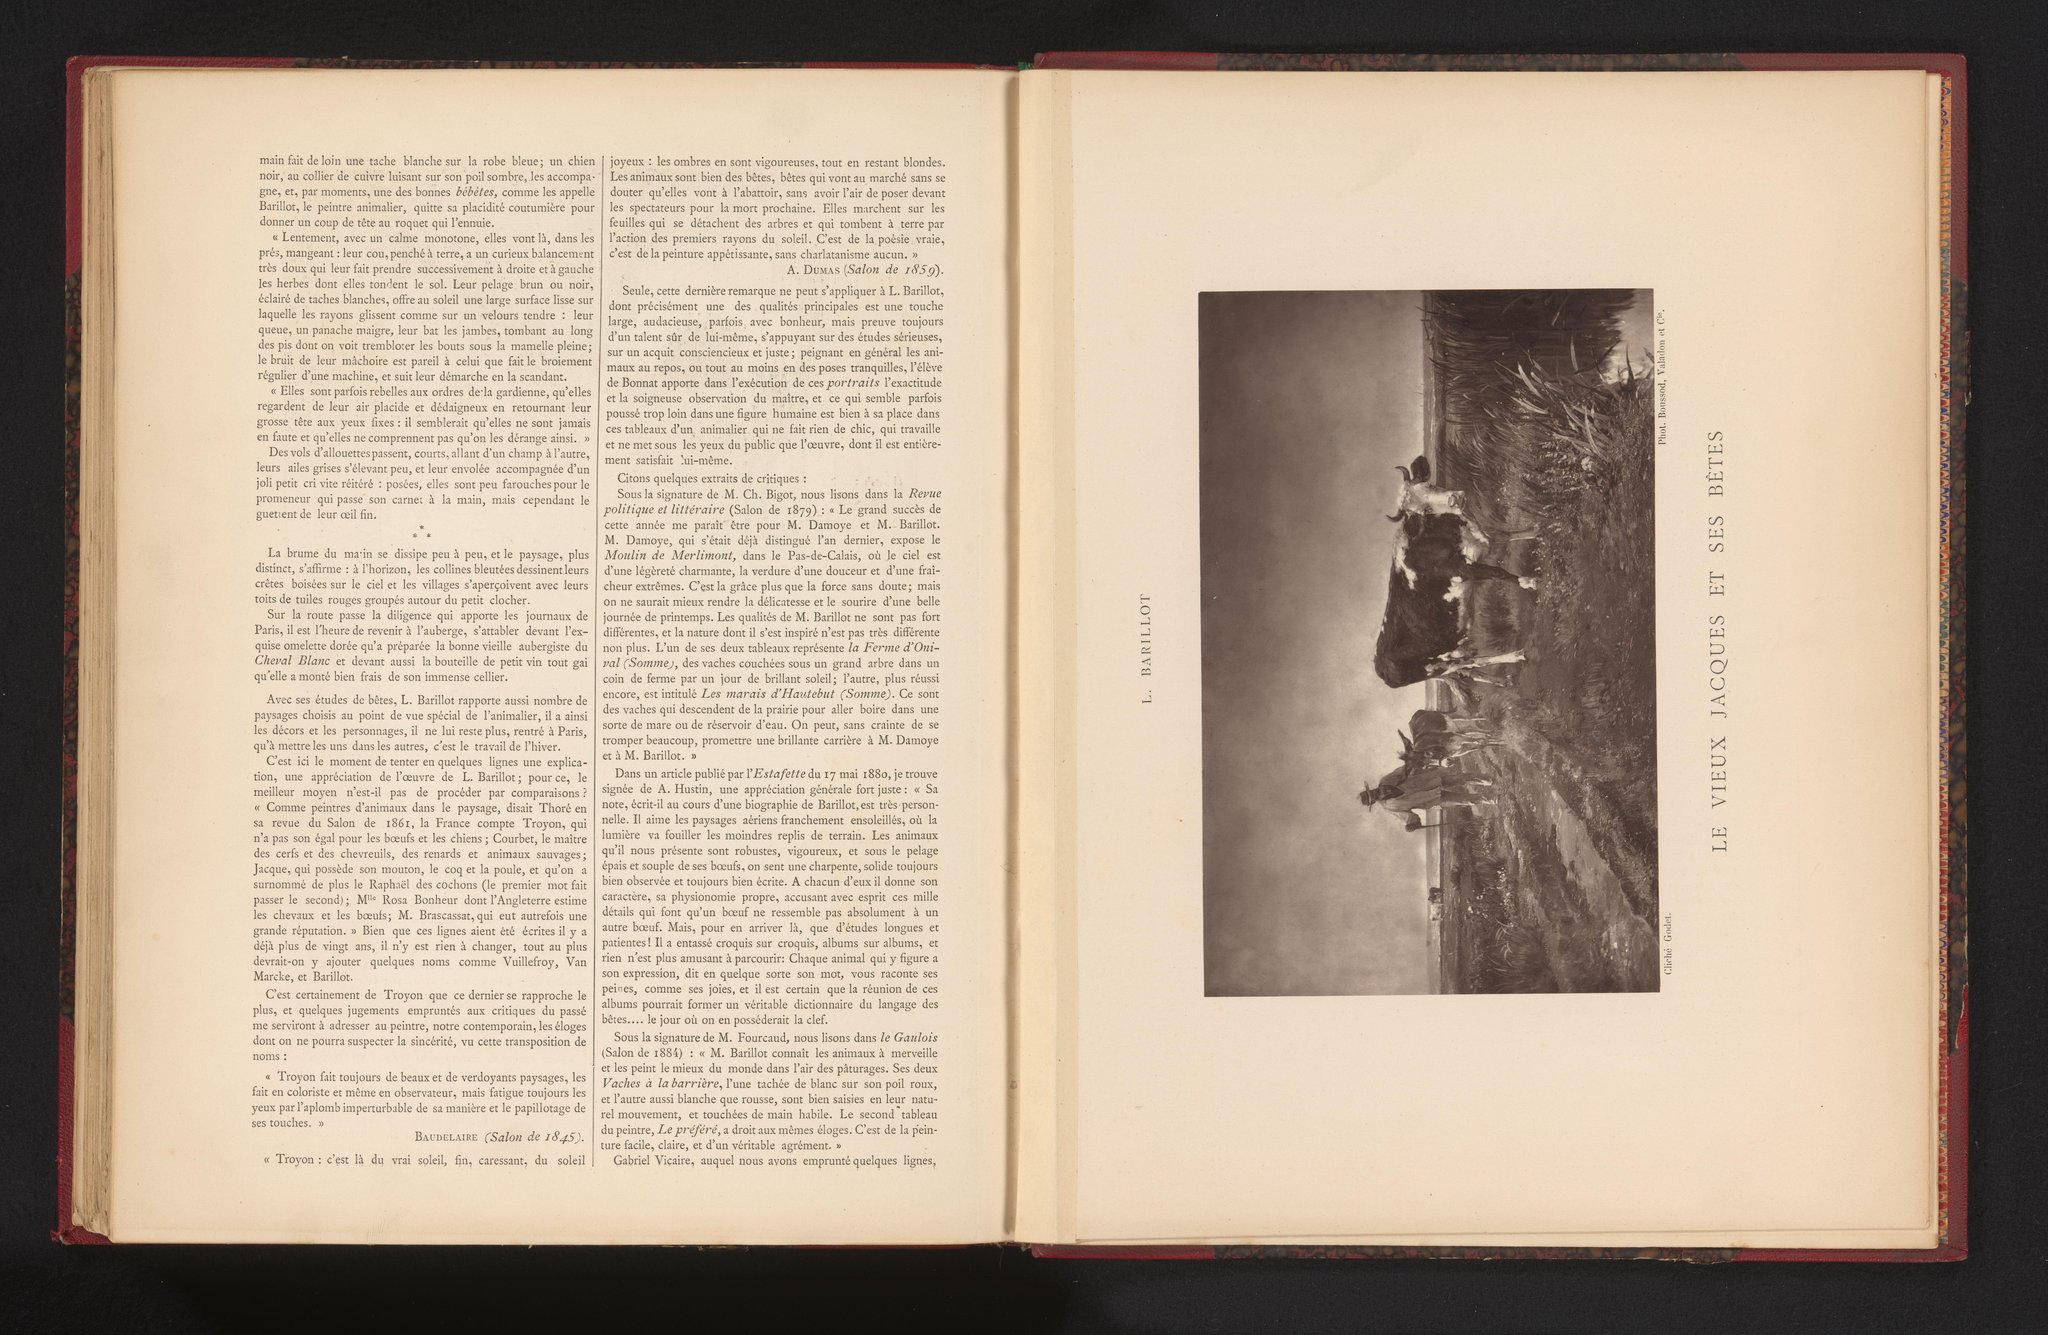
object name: photomechanical print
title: Le vieux Jacques et ses bêtes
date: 1879-1884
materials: paper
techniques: woodburytype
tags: cattle driving, cattle driver